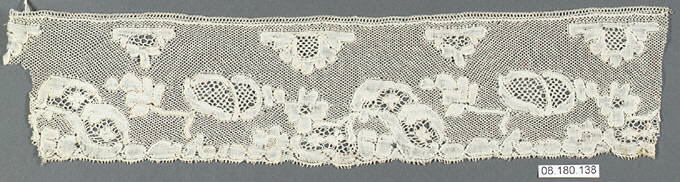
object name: piece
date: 1701-1800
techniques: lace